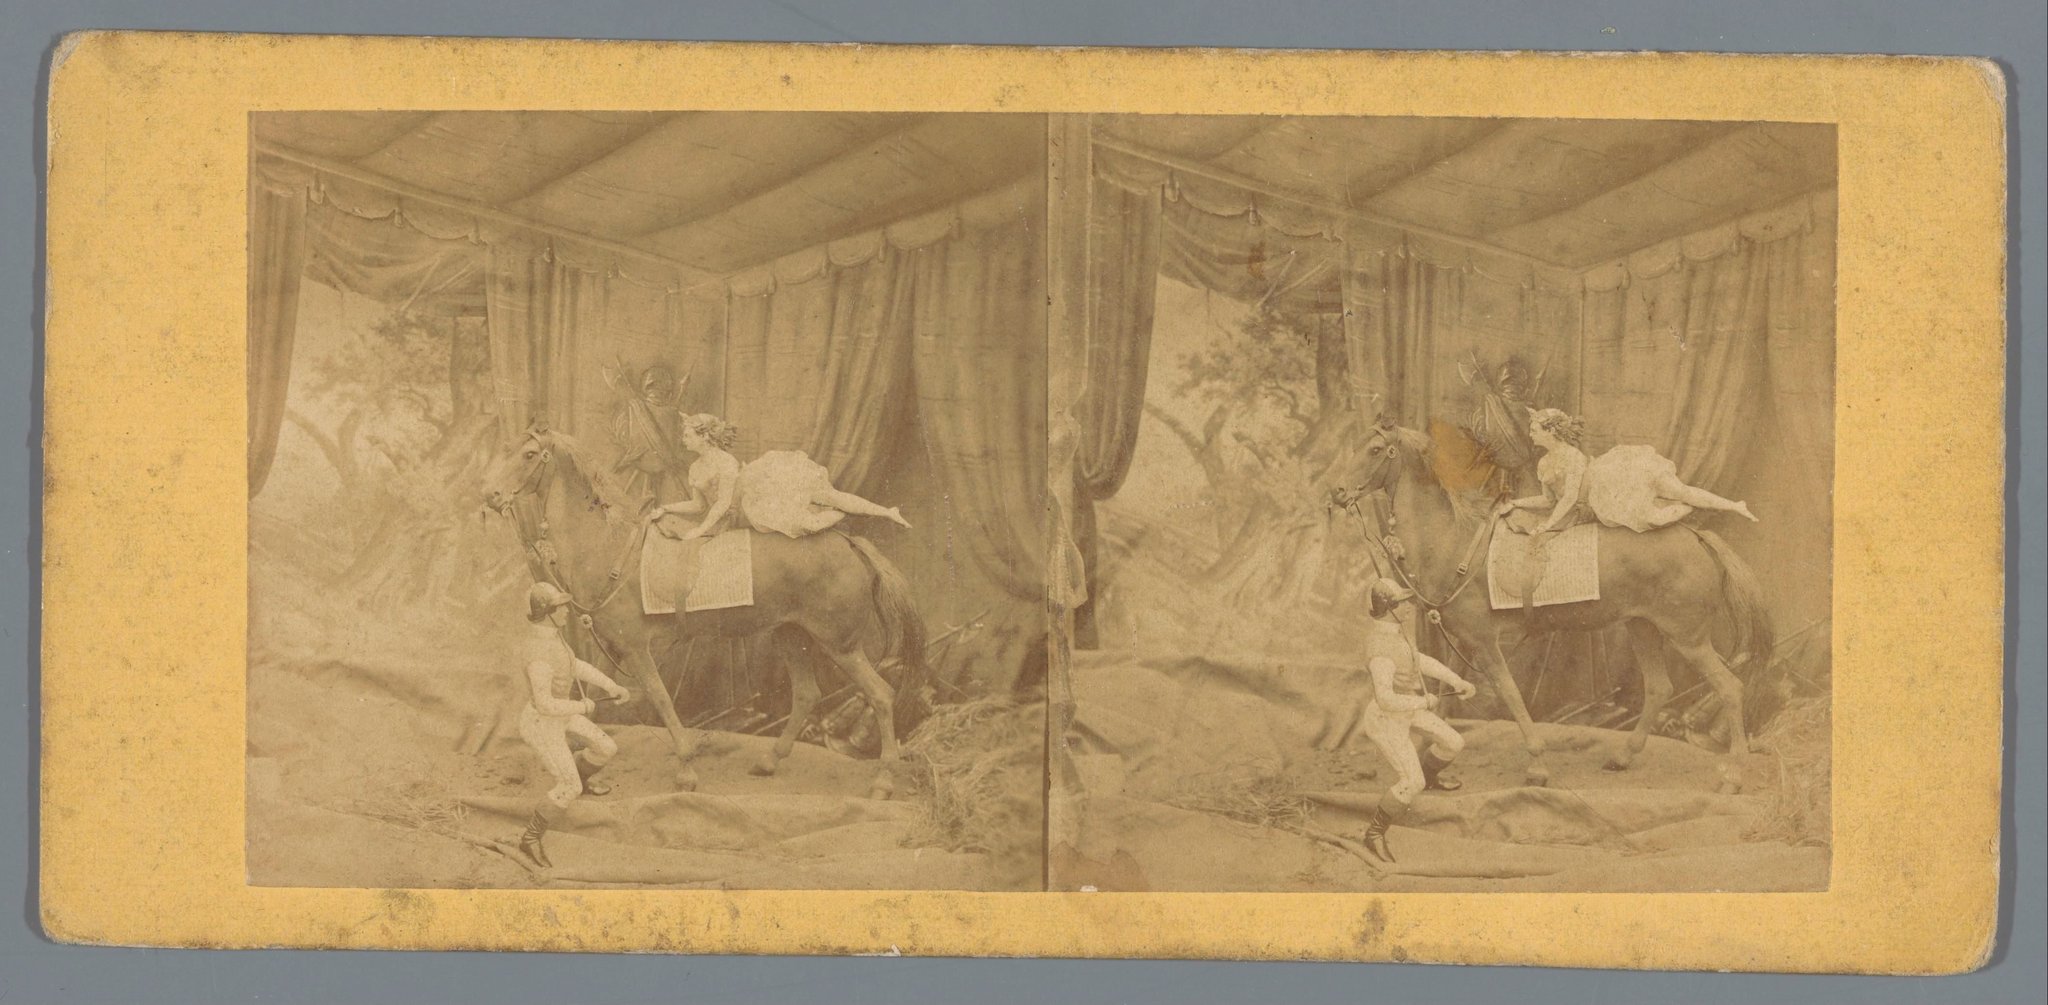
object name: stereograph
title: Enscenering van poppen in een decor, voorstellend een ruiter en een vrouw zijdelings liggend op een paard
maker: Anonymous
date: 1850-1880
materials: cardboard, photographic support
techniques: albumen print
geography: europe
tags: riding a horse, ass, or mule; rider, horseman, (playing with) dolls, horse, europe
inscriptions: number: ‘2326 36’